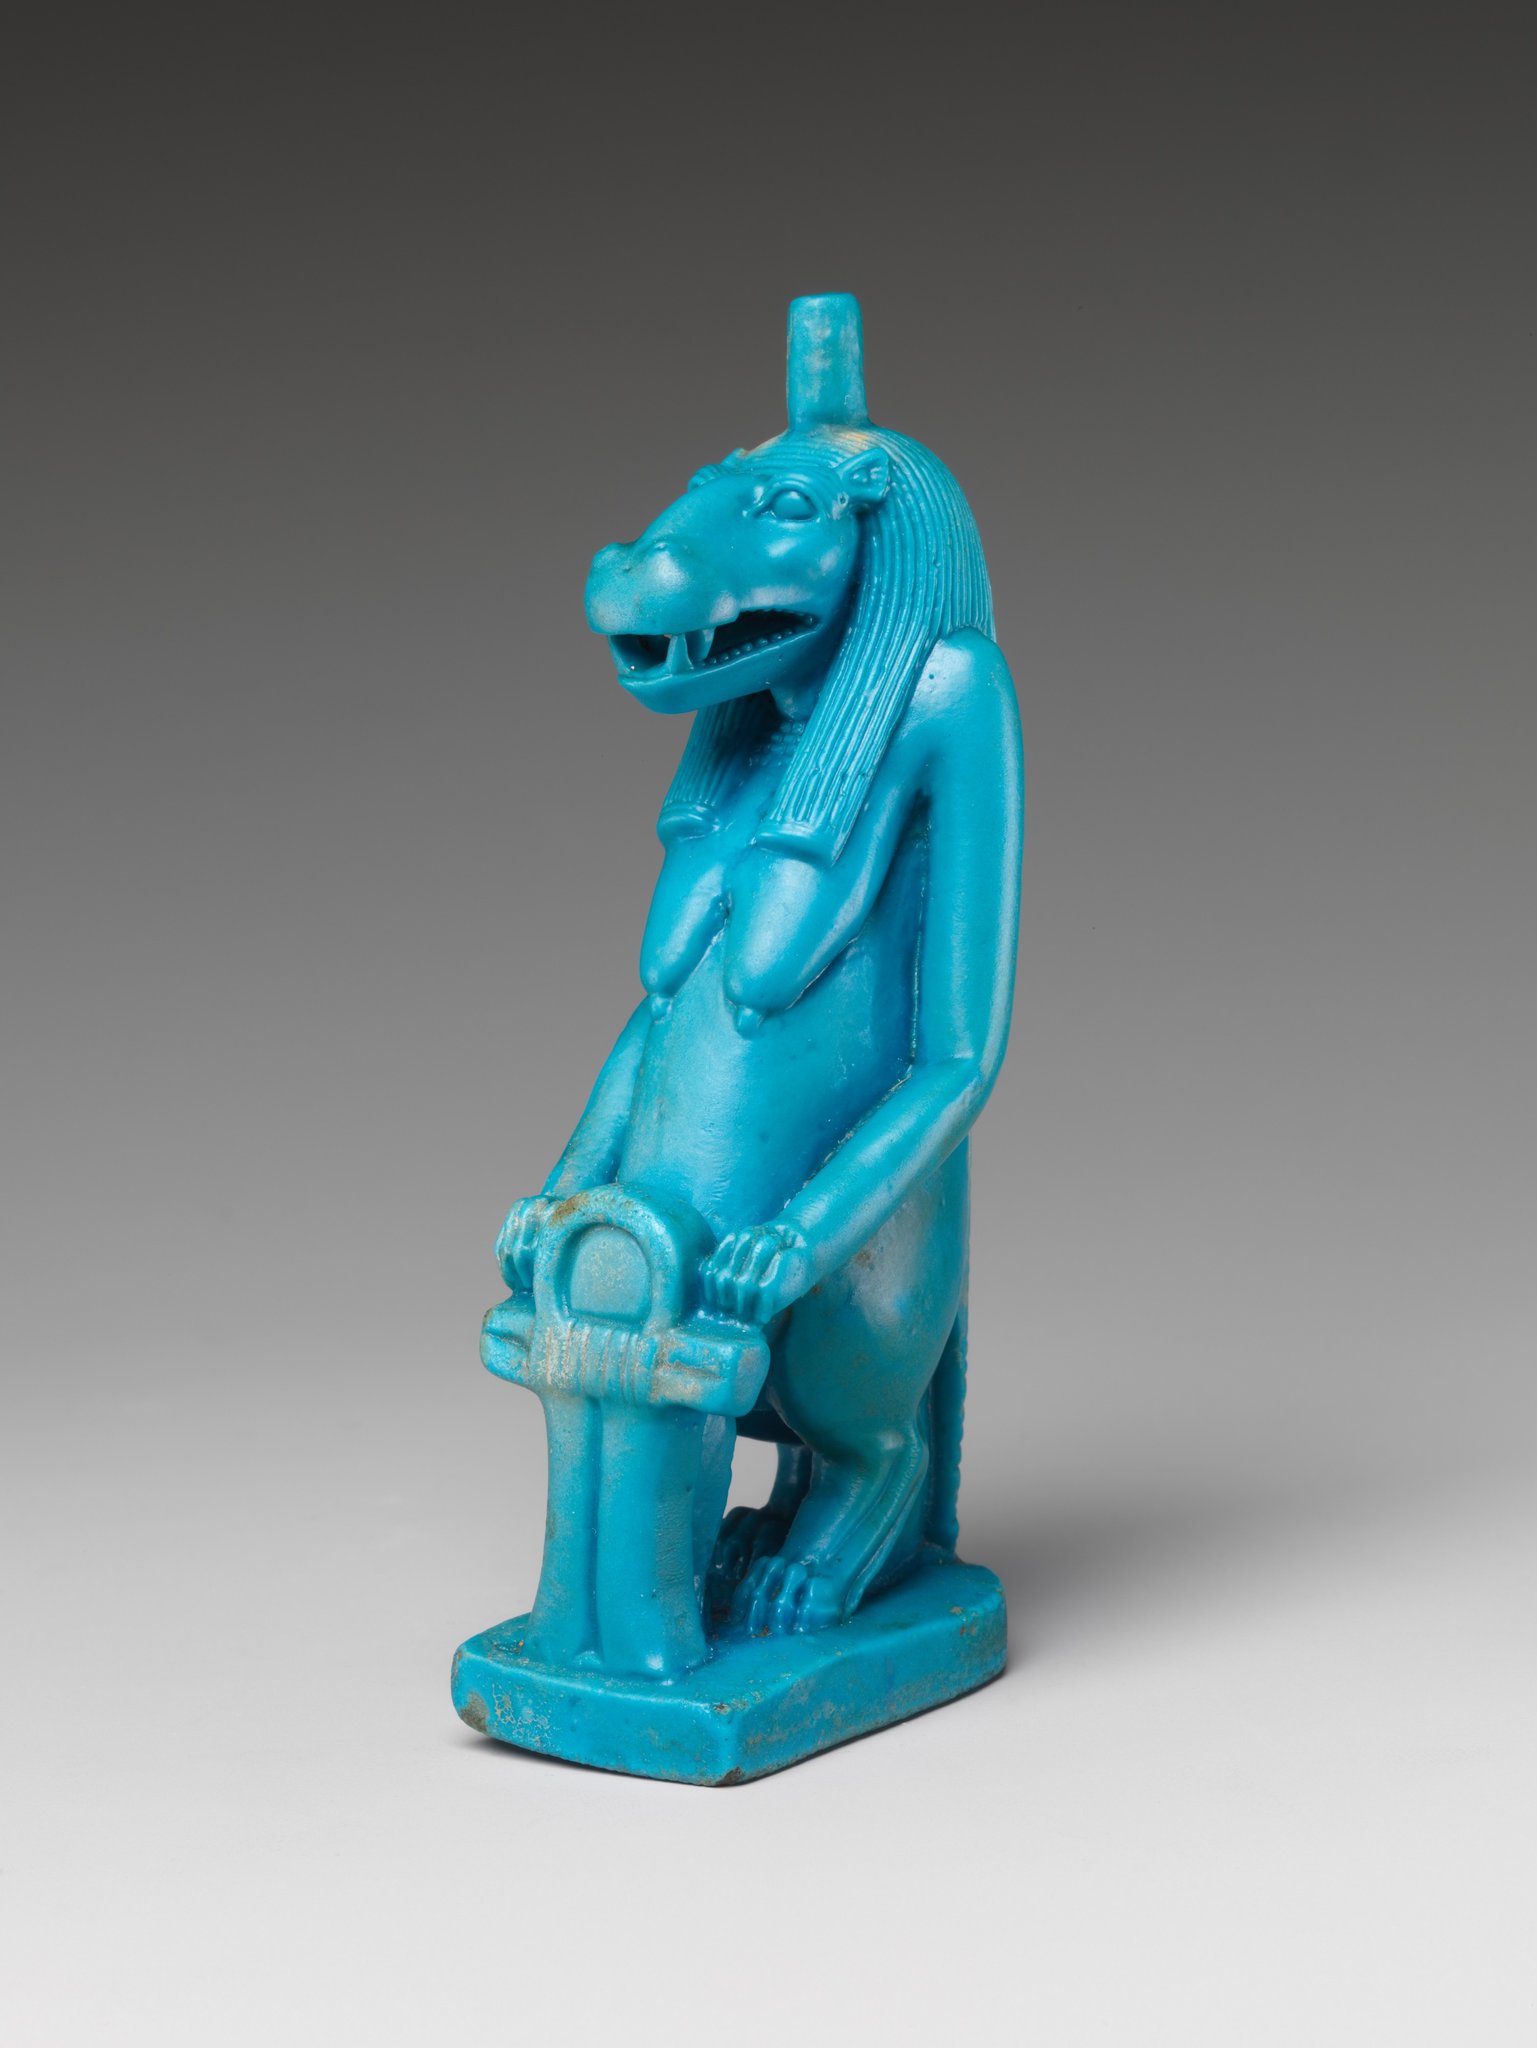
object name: statuette, taweret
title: Statuette of a hippo goddess, probably Taweret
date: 332-330 BCE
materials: faience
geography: egypt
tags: taweret,hippos,goddess